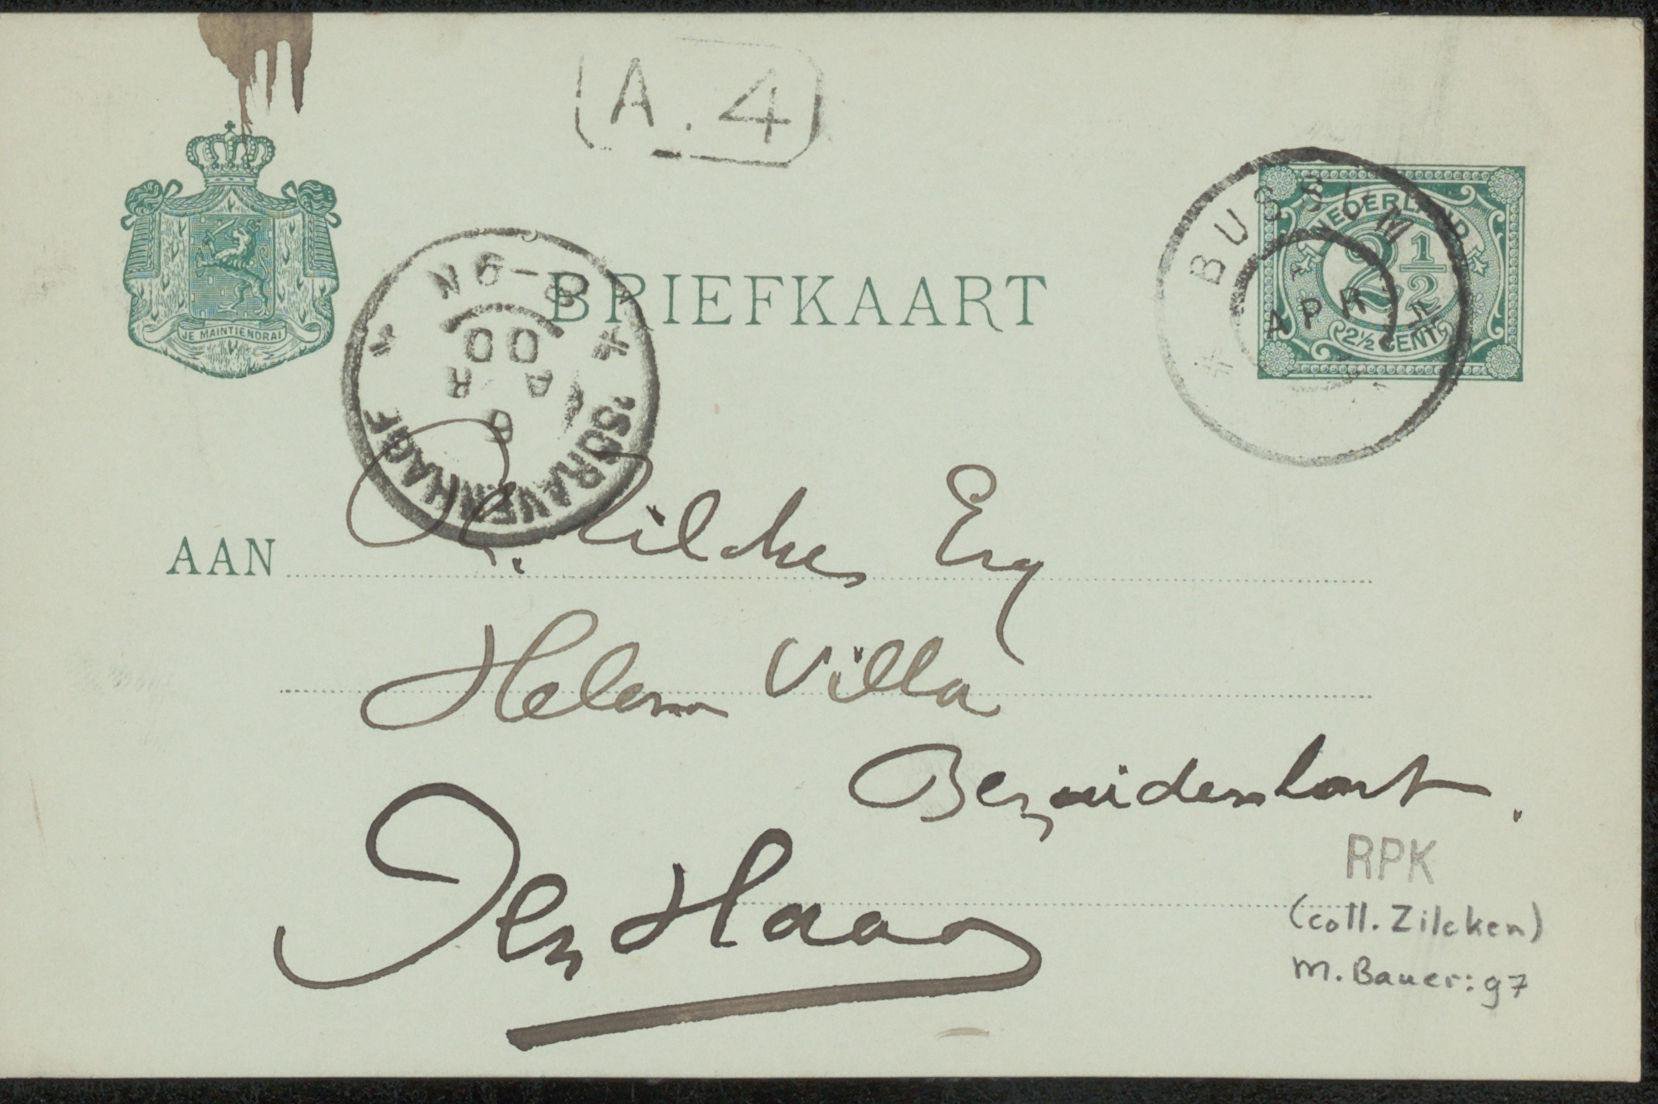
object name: postcard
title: Briefkaart aan Philip Zilcken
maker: marius bauer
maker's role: draughtsman, print maker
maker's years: 1867-1932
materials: cardboard, ink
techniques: pen, writing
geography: the hague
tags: amsterdam, print maker, willem witsen, painter, draughtsman, philip zilcken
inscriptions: collector's mark: ‘RPK’